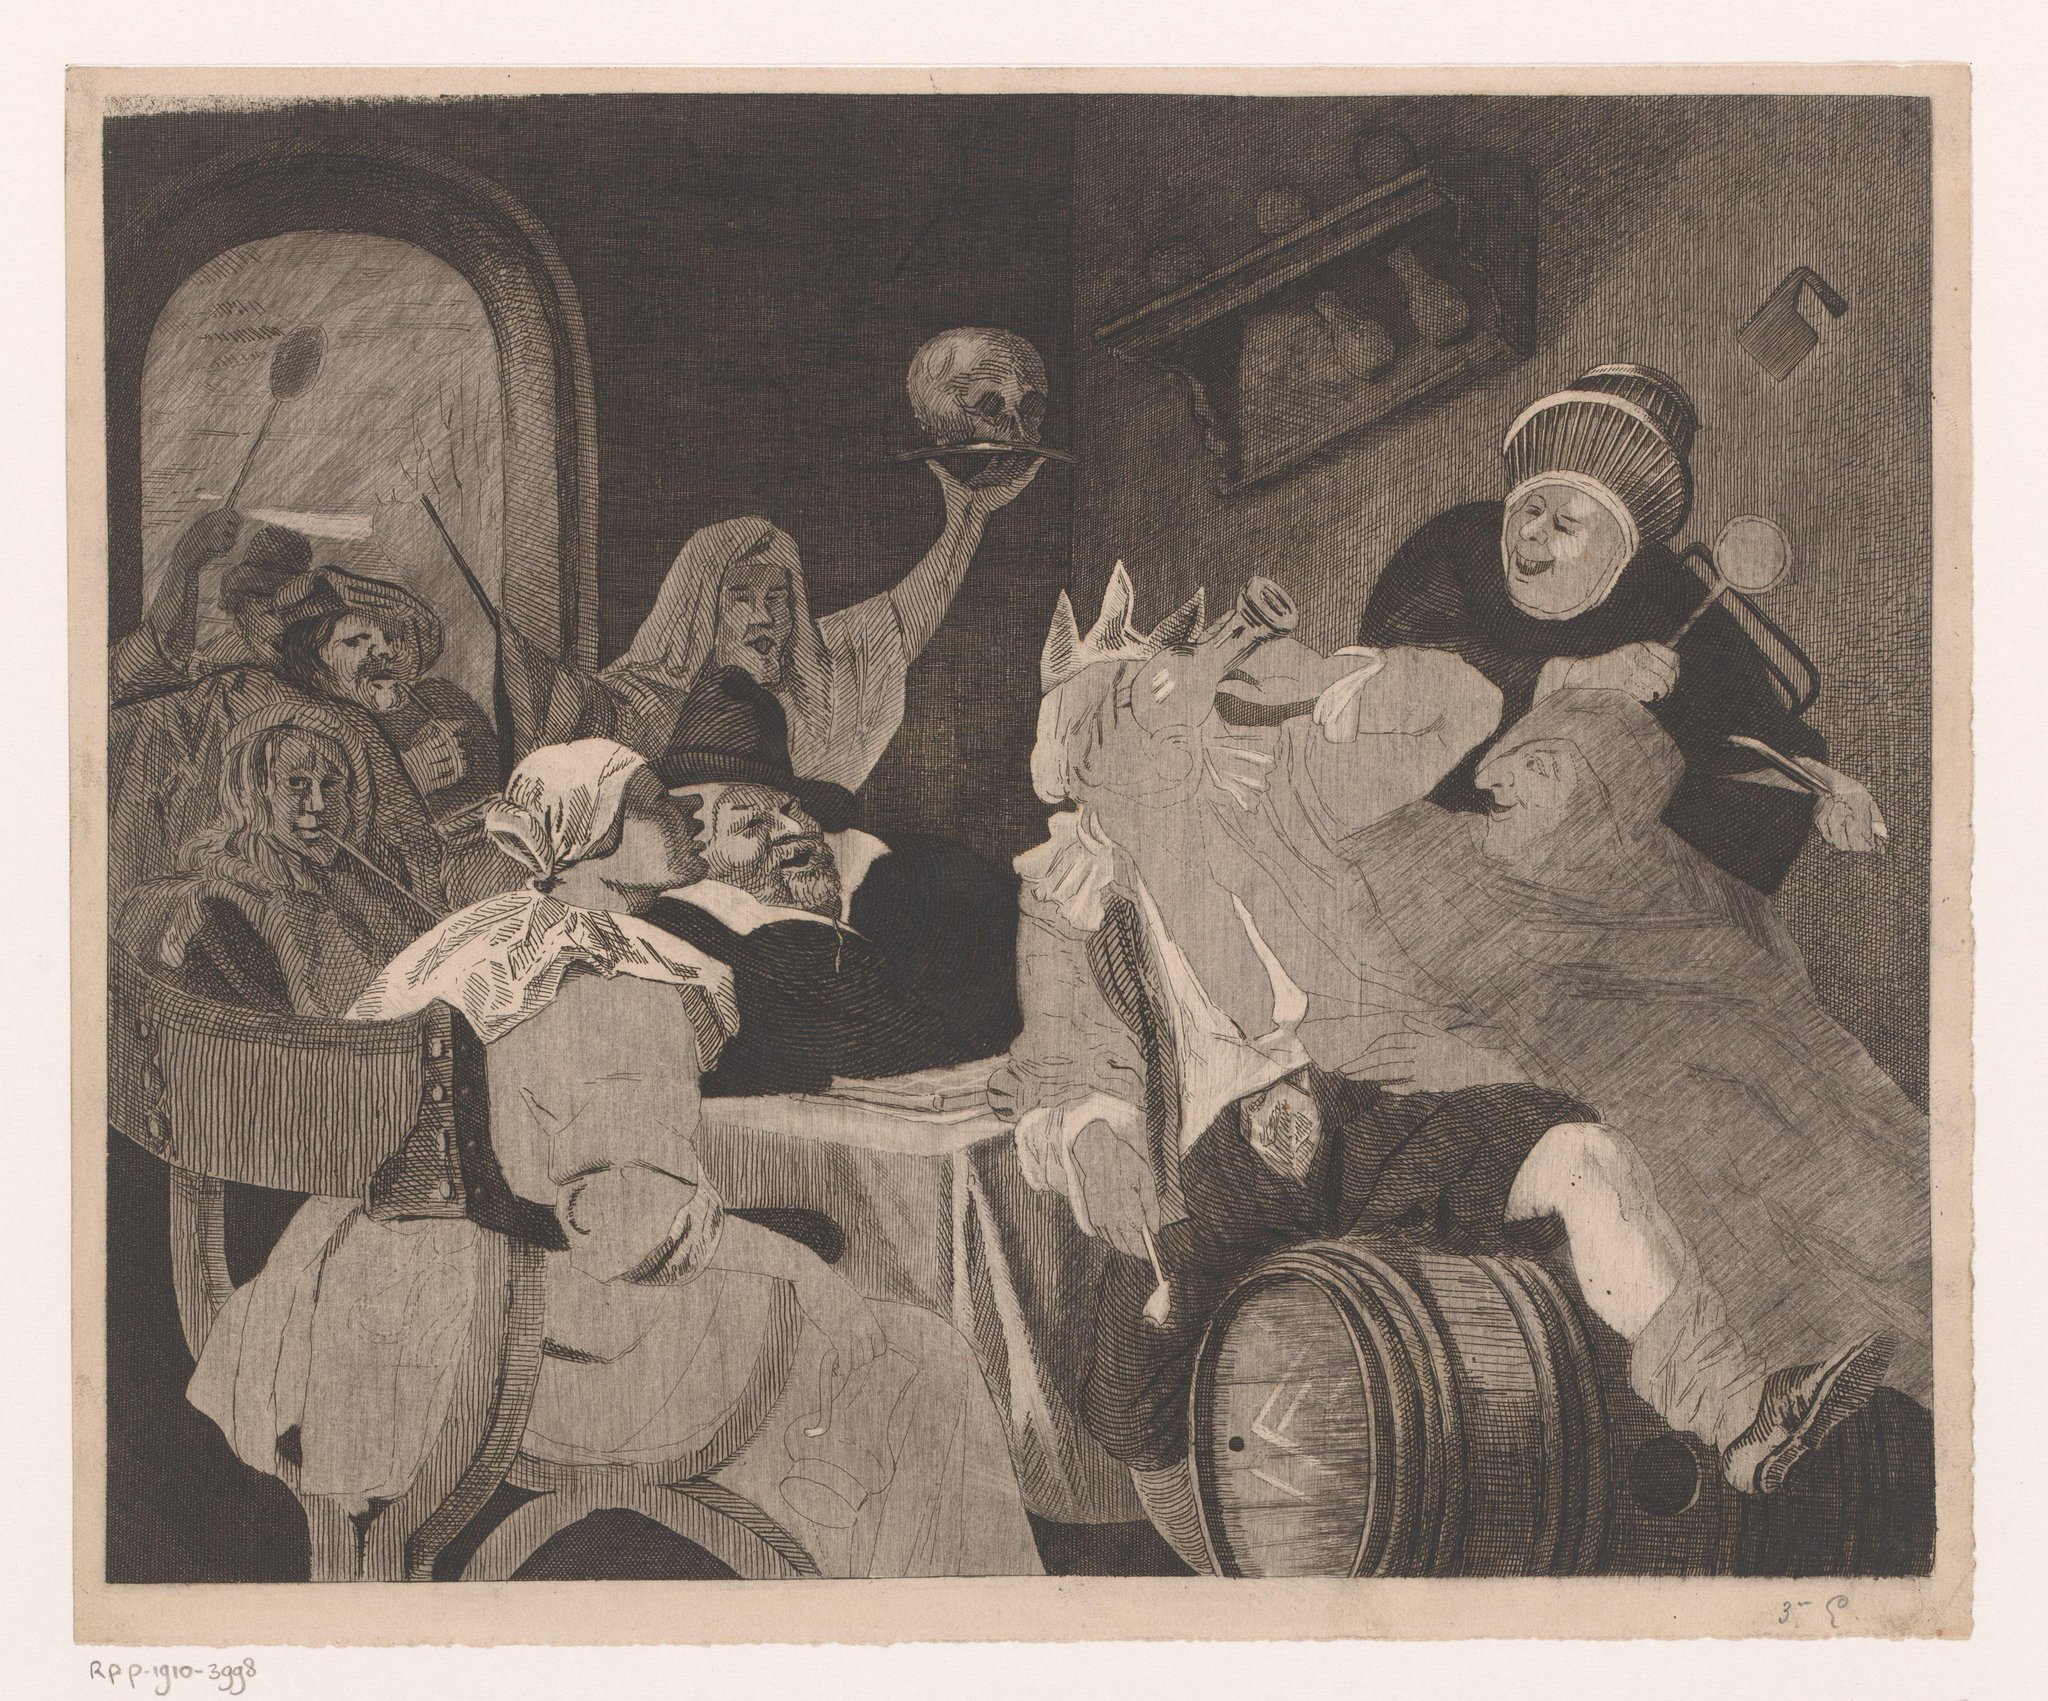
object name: print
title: Feestend gezelschap met een drinkende man met kroon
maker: louis jaugey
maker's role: print maker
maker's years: 1837-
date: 1850-1899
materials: paper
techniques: etching, intaglio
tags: feasts of saints (and their relics), periodic celebrations, popular feasts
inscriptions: collector's mark: Lugt 2228